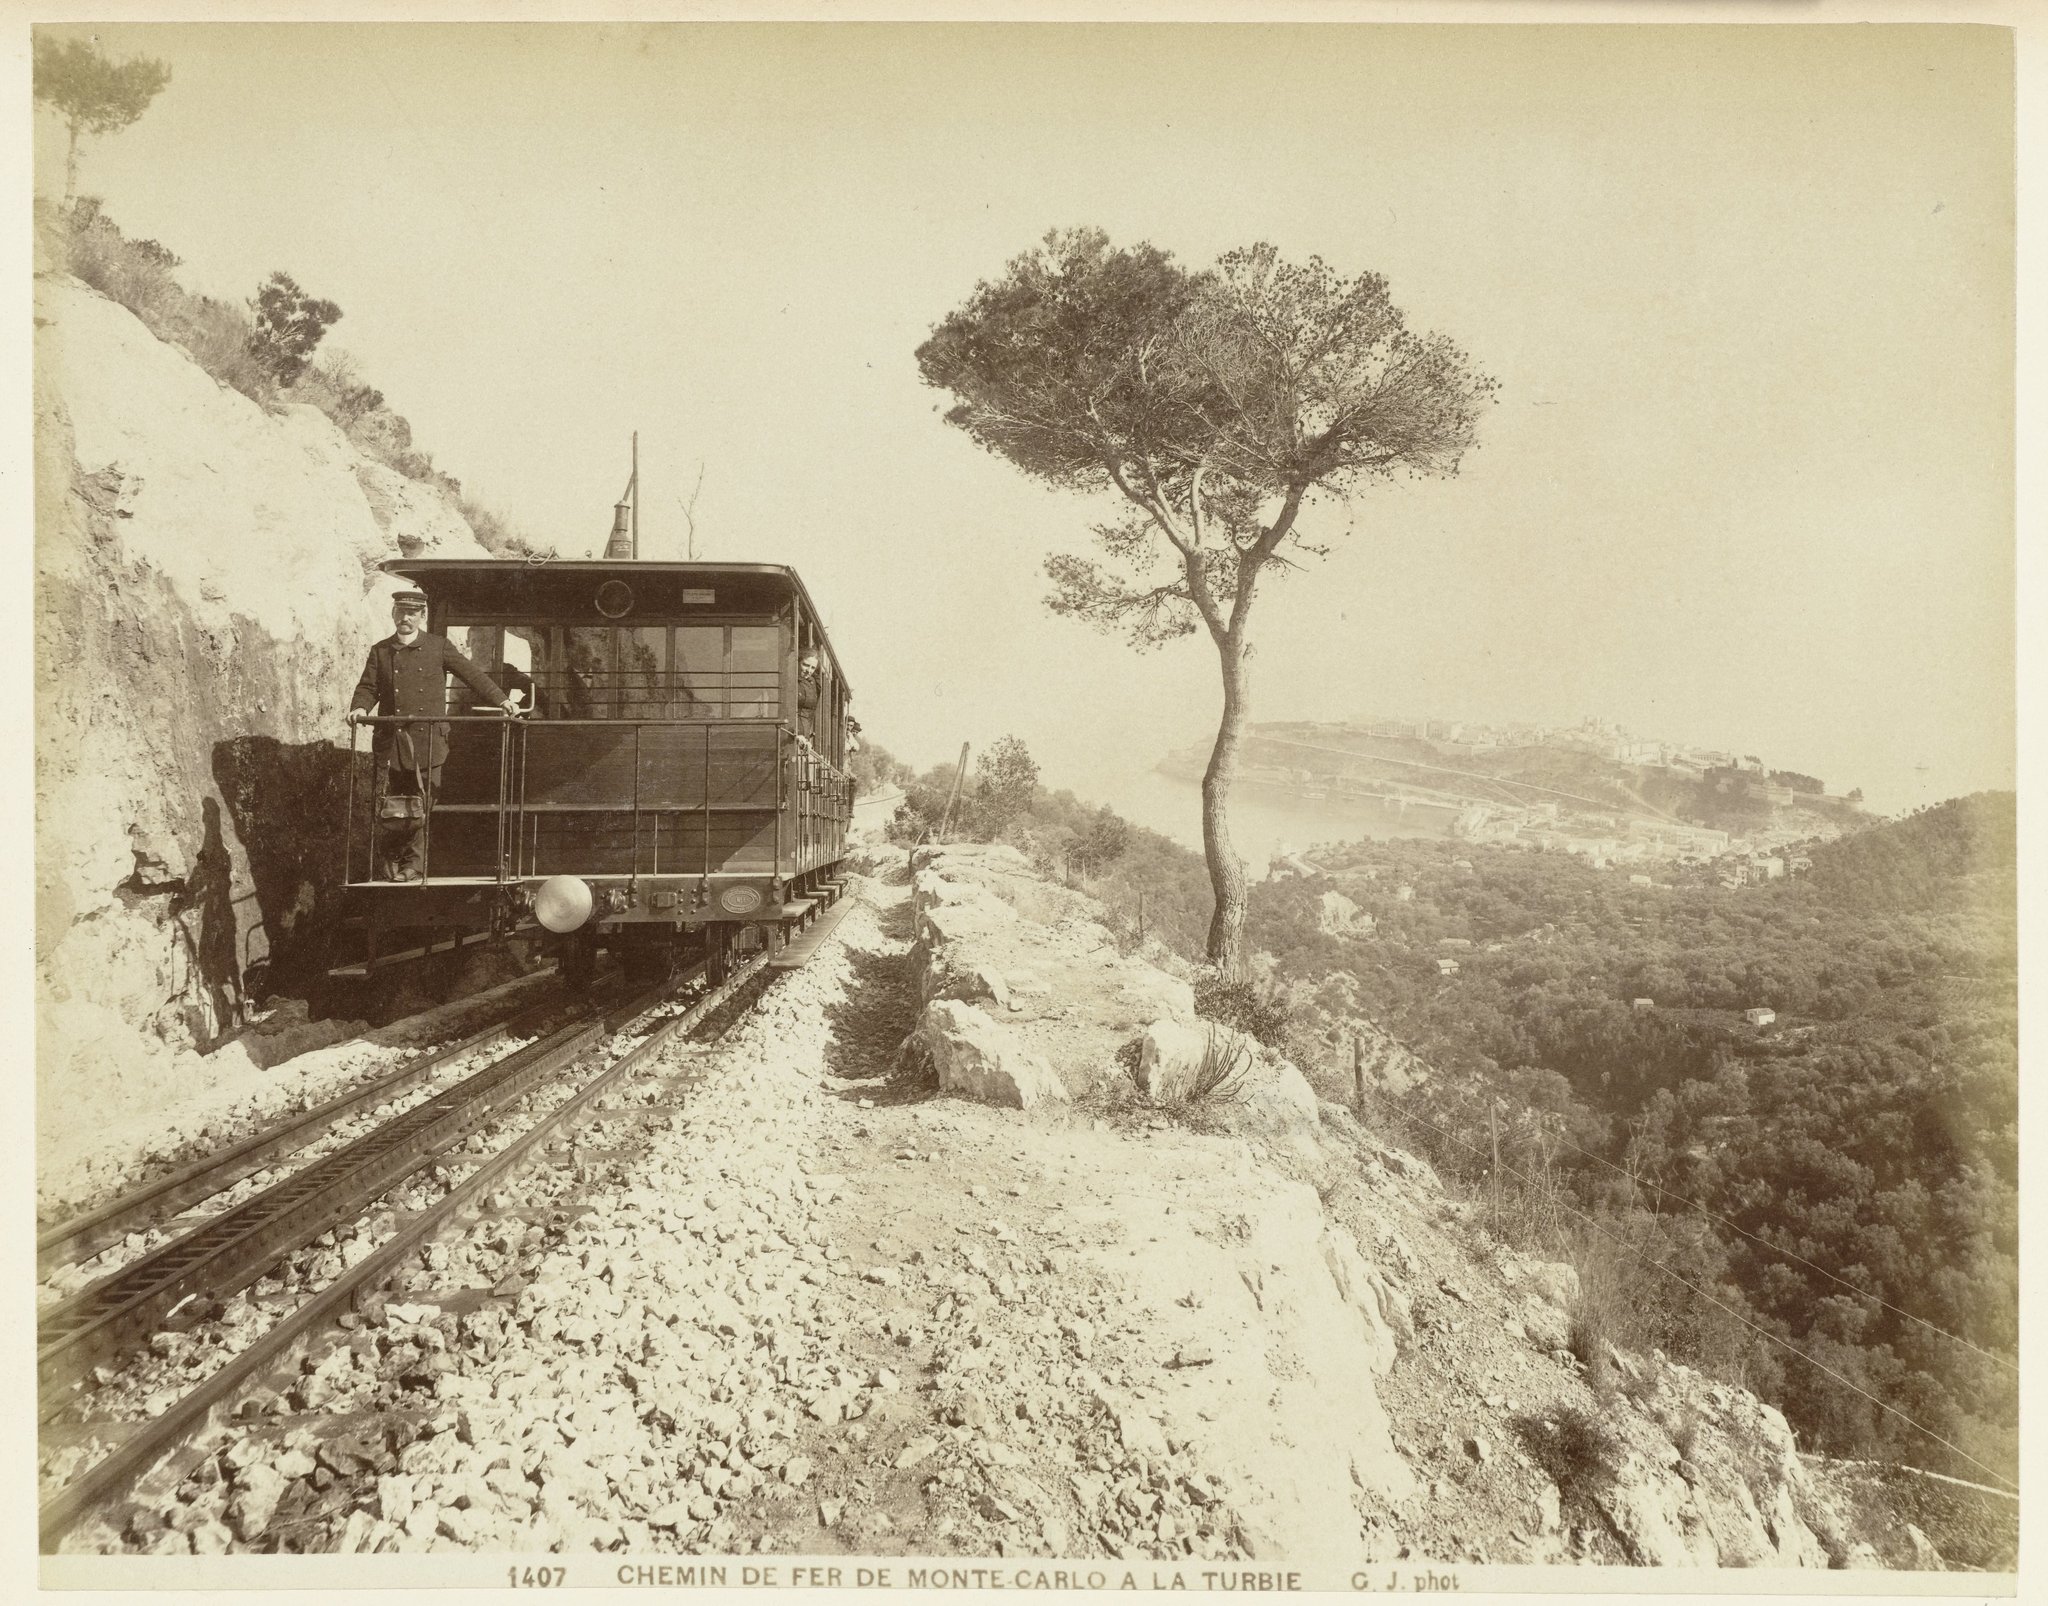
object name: photograph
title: 1407 Chemin de fer de Monte Carlo a la Turbie, G.J. Phot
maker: henry pauw van wieldrecht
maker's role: fotograaf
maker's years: 1863-1912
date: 1886-1896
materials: cardboard, photographic support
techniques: albumen print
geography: france